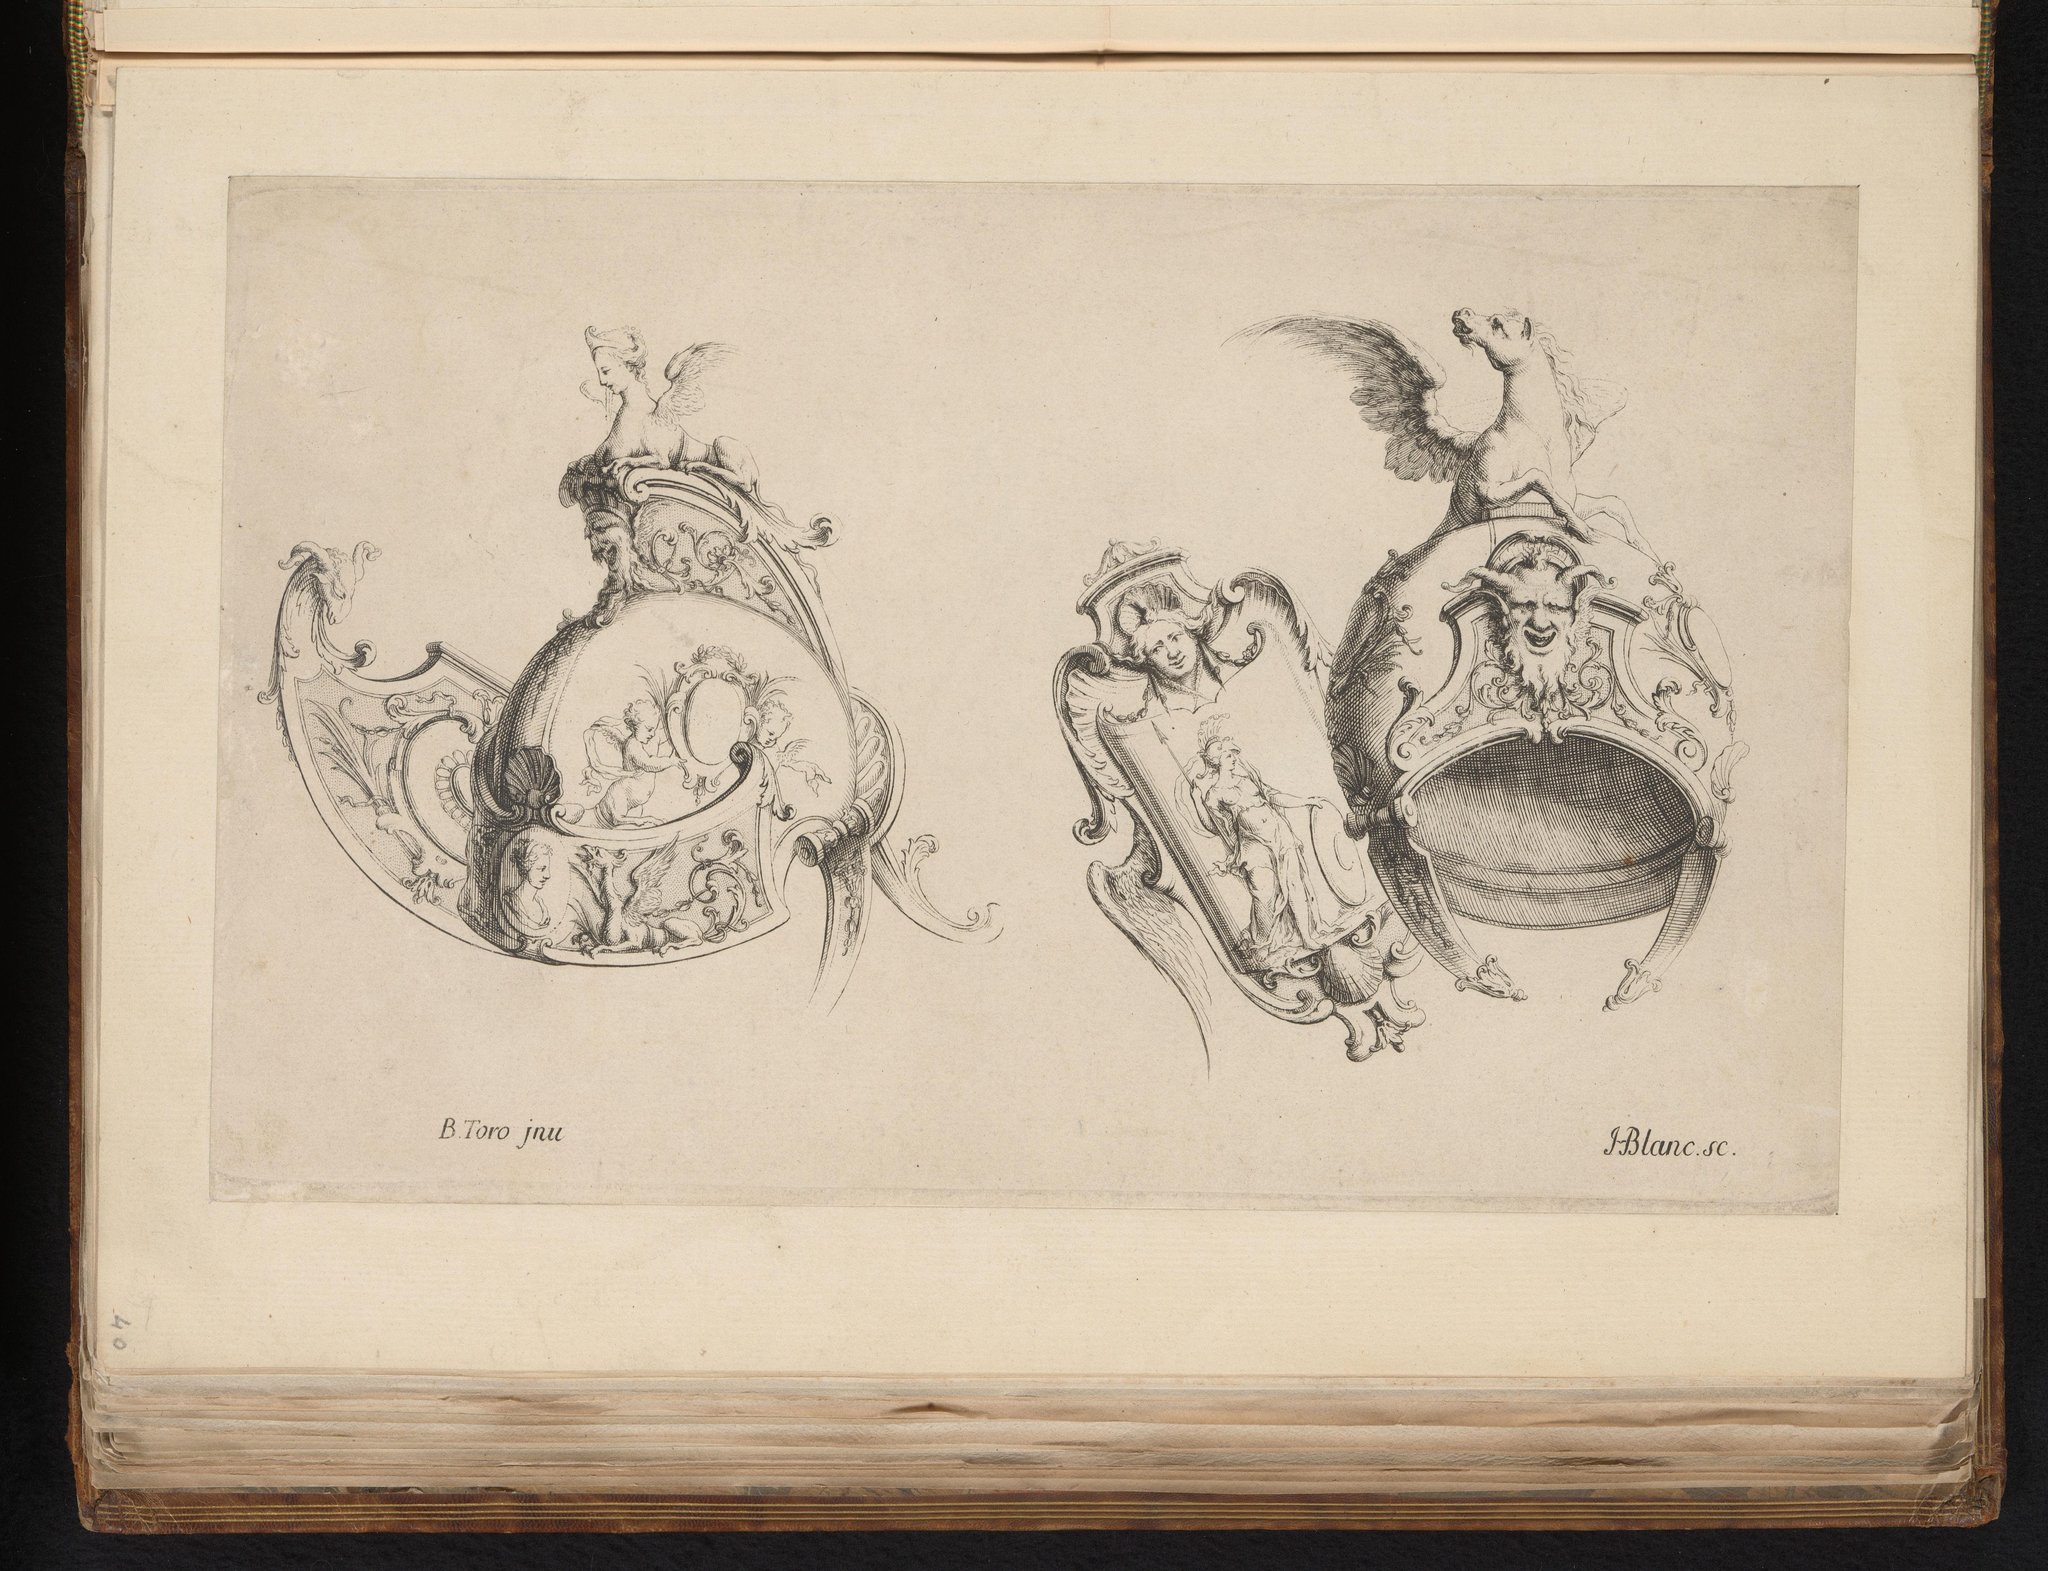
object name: ornament print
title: Twee helmen en een schild met ornamenten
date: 1682-1734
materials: paper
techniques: etching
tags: helmet, protective weapons: shield, ornaments ~ art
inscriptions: collector's mark: Lugt 2228, collector's mark: Lugt 2760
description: Prent maakt deel uit van een serie van zes prenten.